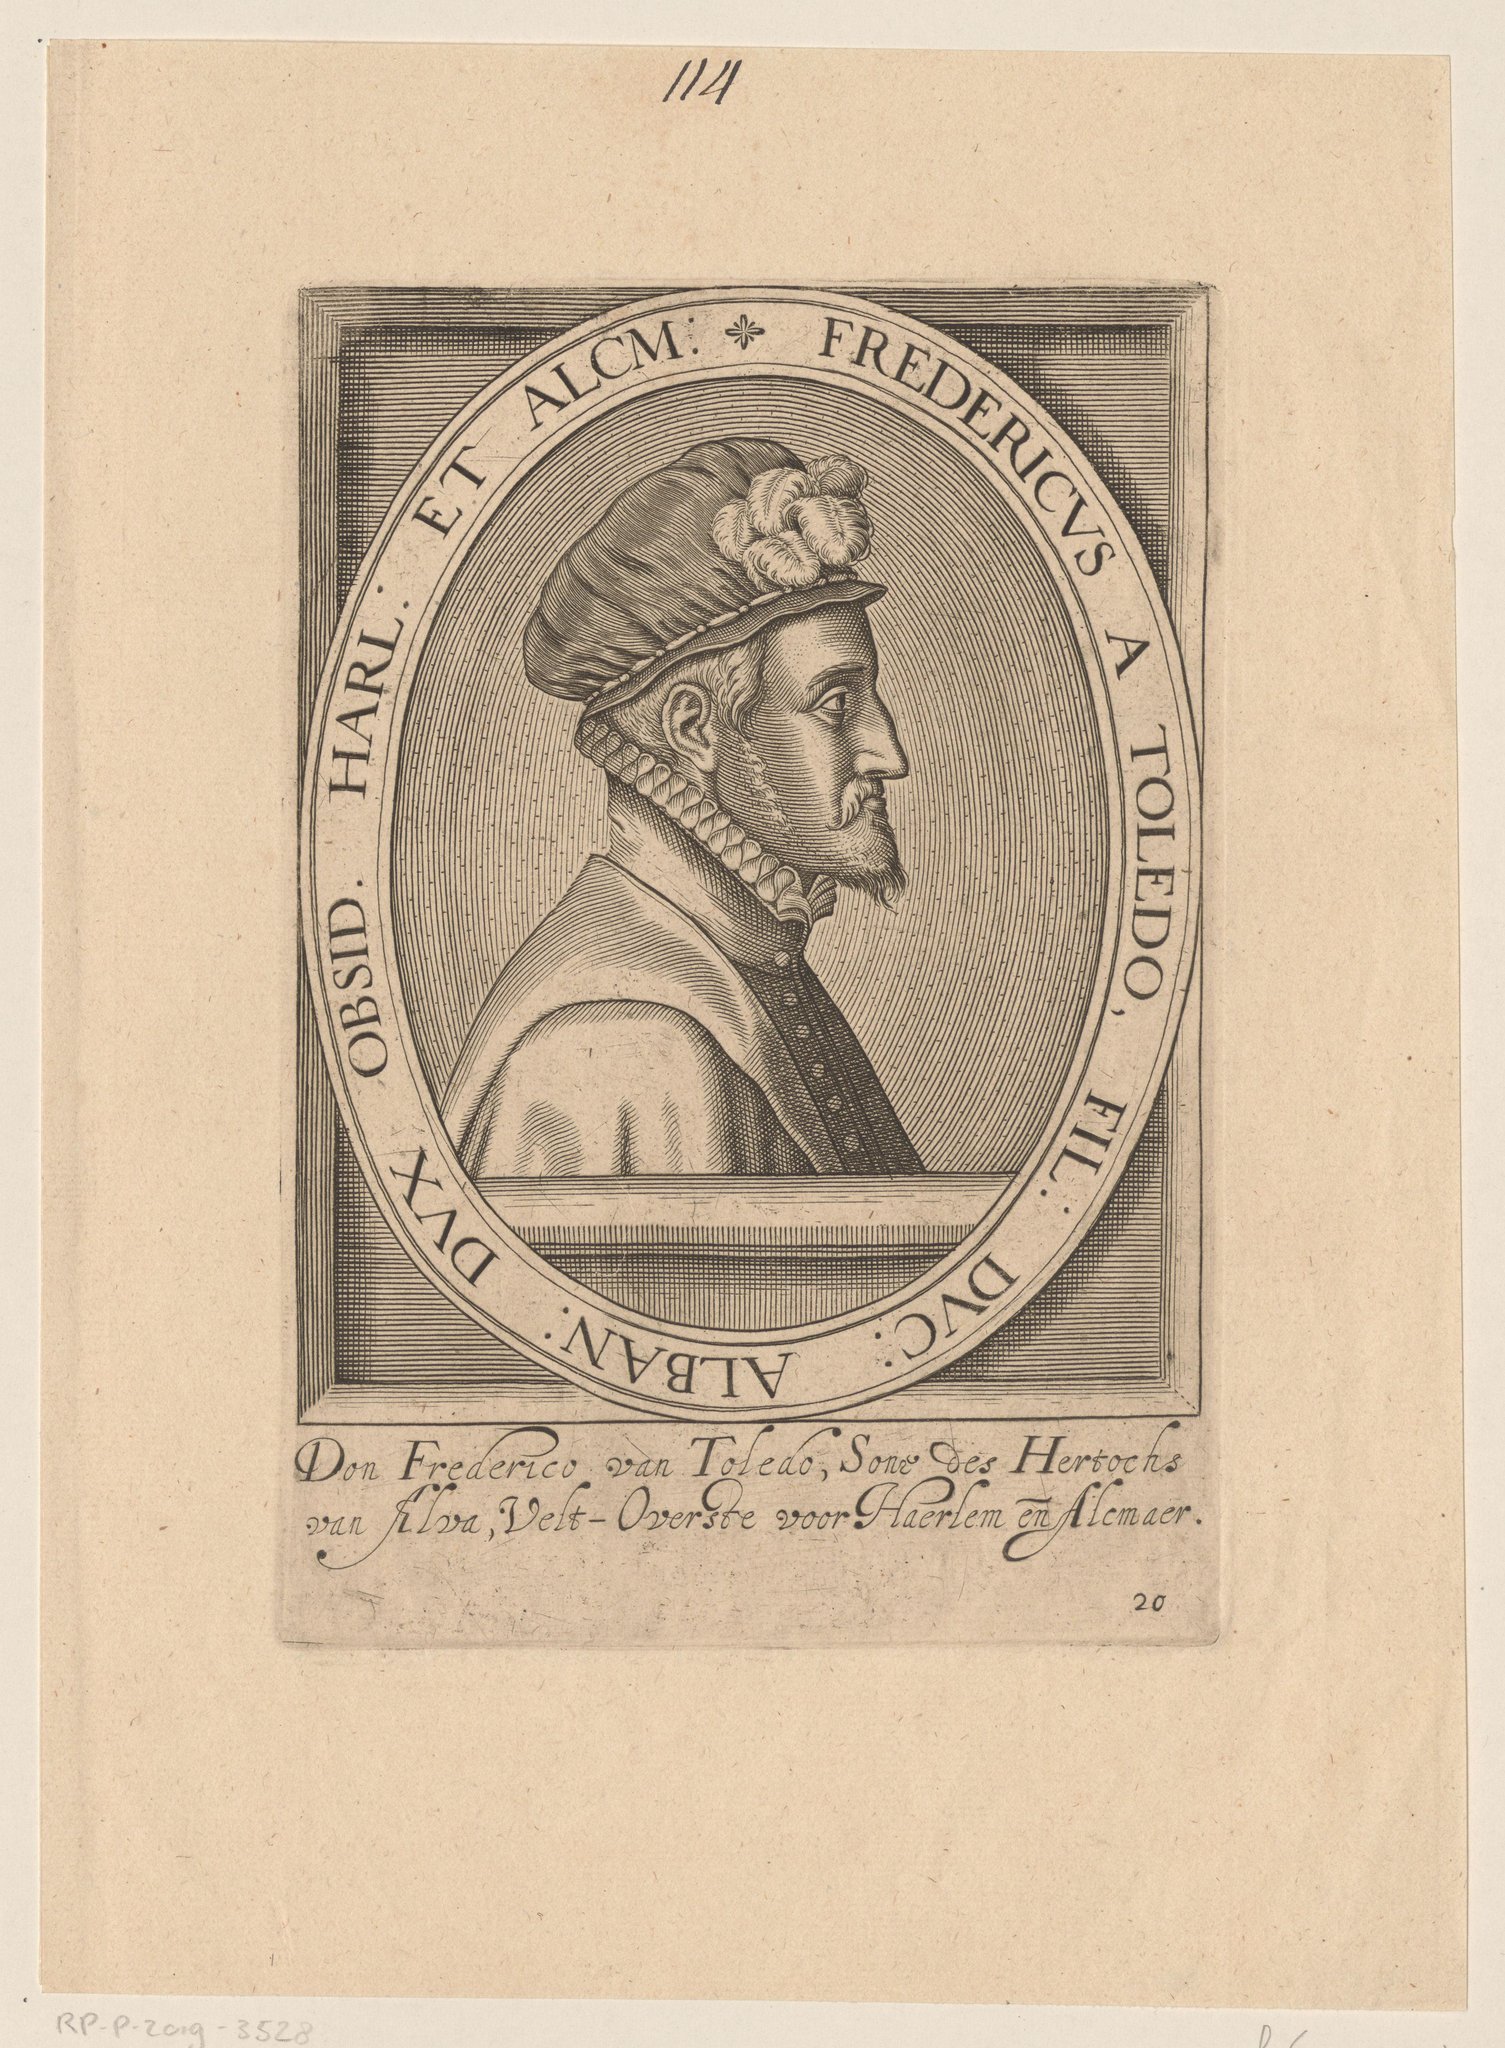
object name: print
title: Portret van Fadrique Álvarez de Toledo, hertog van Alva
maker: Anonymous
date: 1640-1699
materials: paper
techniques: engraving, etching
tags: historical persons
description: Prent, met of zonder rand, komt voor in verschillende edities en vertalingen van: Meteren, Emanuel van. Historie der Nederlandscher ende haerder na-buren oorlogen ende geschiedenissen (...).